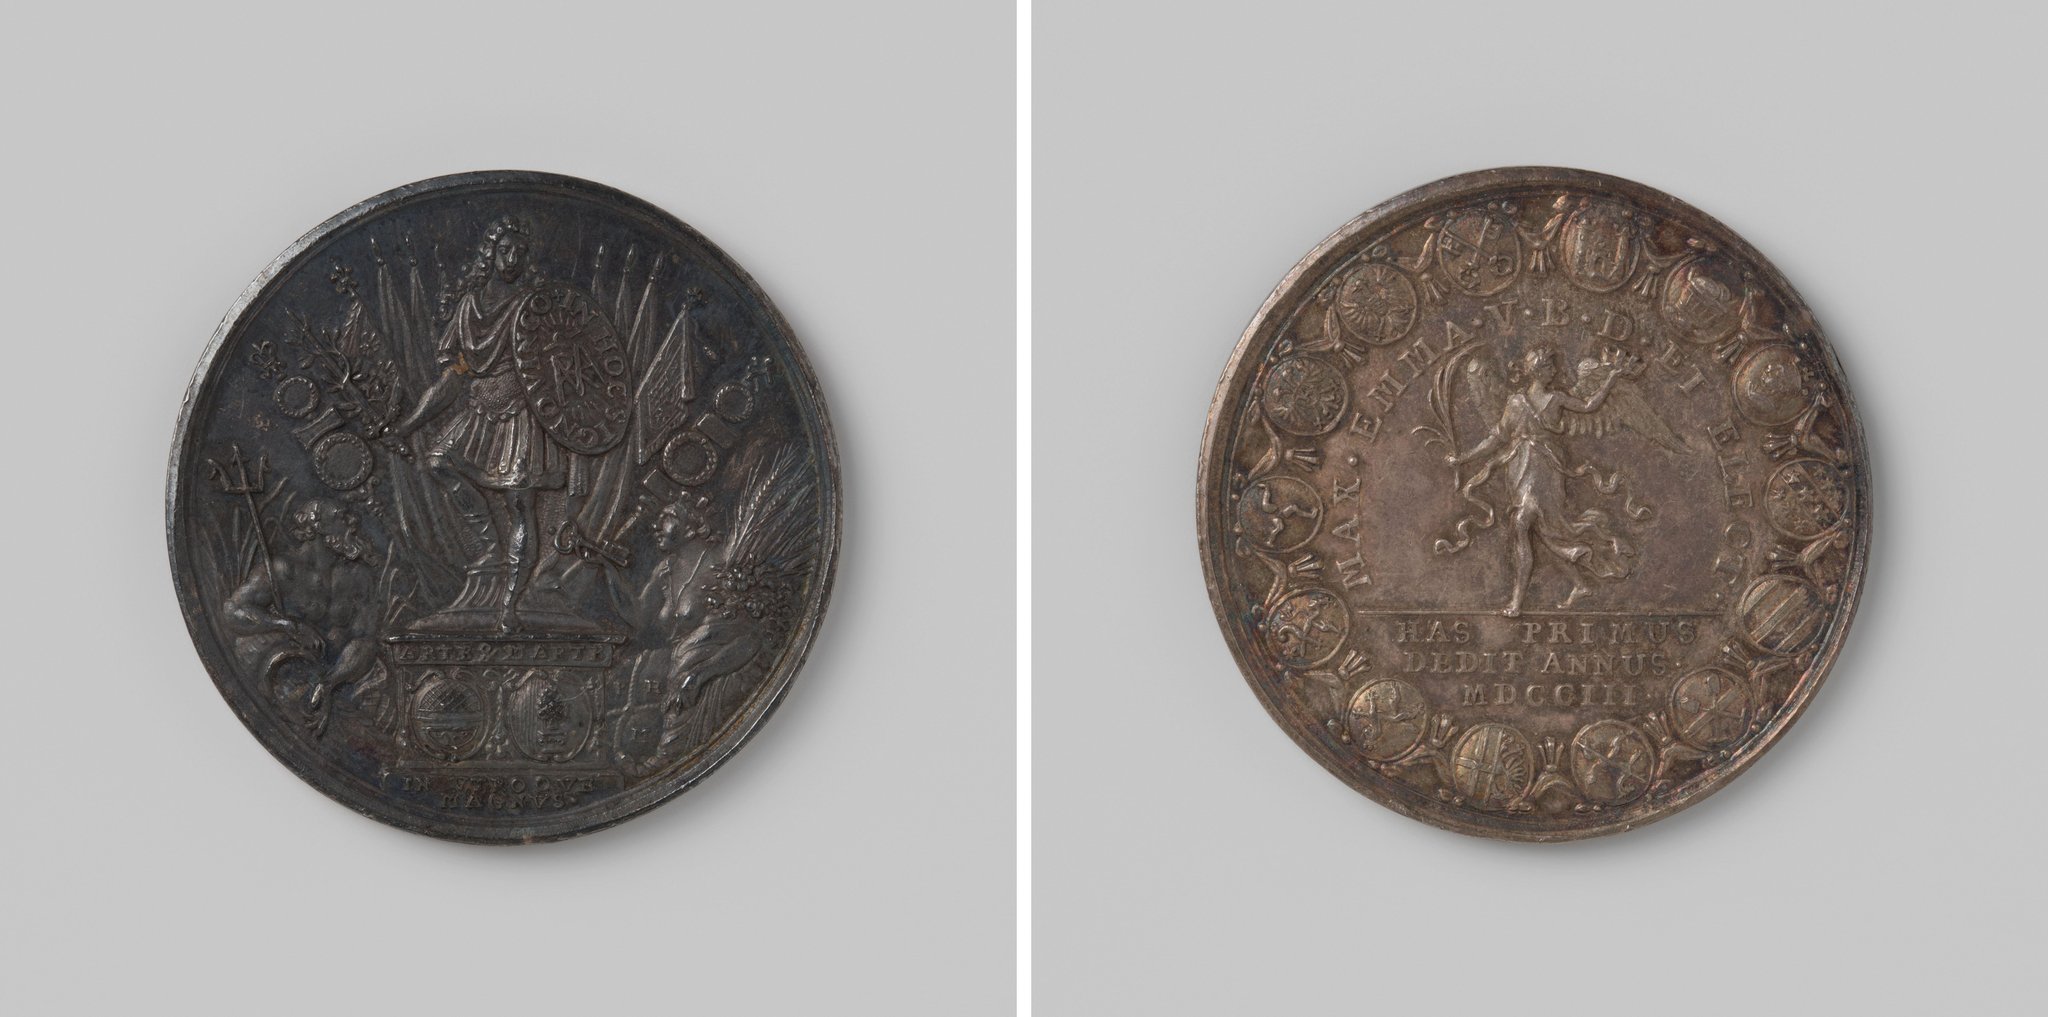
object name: history medal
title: Maximiliaan II Emanuel, keurvorst van Beieren op het geluk van de Beierse wapenen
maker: philipp heinrich müller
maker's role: medailleur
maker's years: 1654-1719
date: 1703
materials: silver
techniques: striking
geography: nuremberg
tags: maximiliaan ii emanuel (keurvorst van beieren)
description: Zilveren penning. Voorzijde: tussen riviergod met drietand en waterkruik en knielende vrouw met hoorn van overvloed en sleutel staat op voetstuk met opschrift en wapenschilden keurvorst in Romeinse kledij met schild en met lauwertakken omvlochten zwaard voor verschillende veldtekens. Keerzijde: gevleugelde Overwinning met palmtak en kroon in handen boven opschrift, binnen omschrift en rand van veertien wapenschilden.